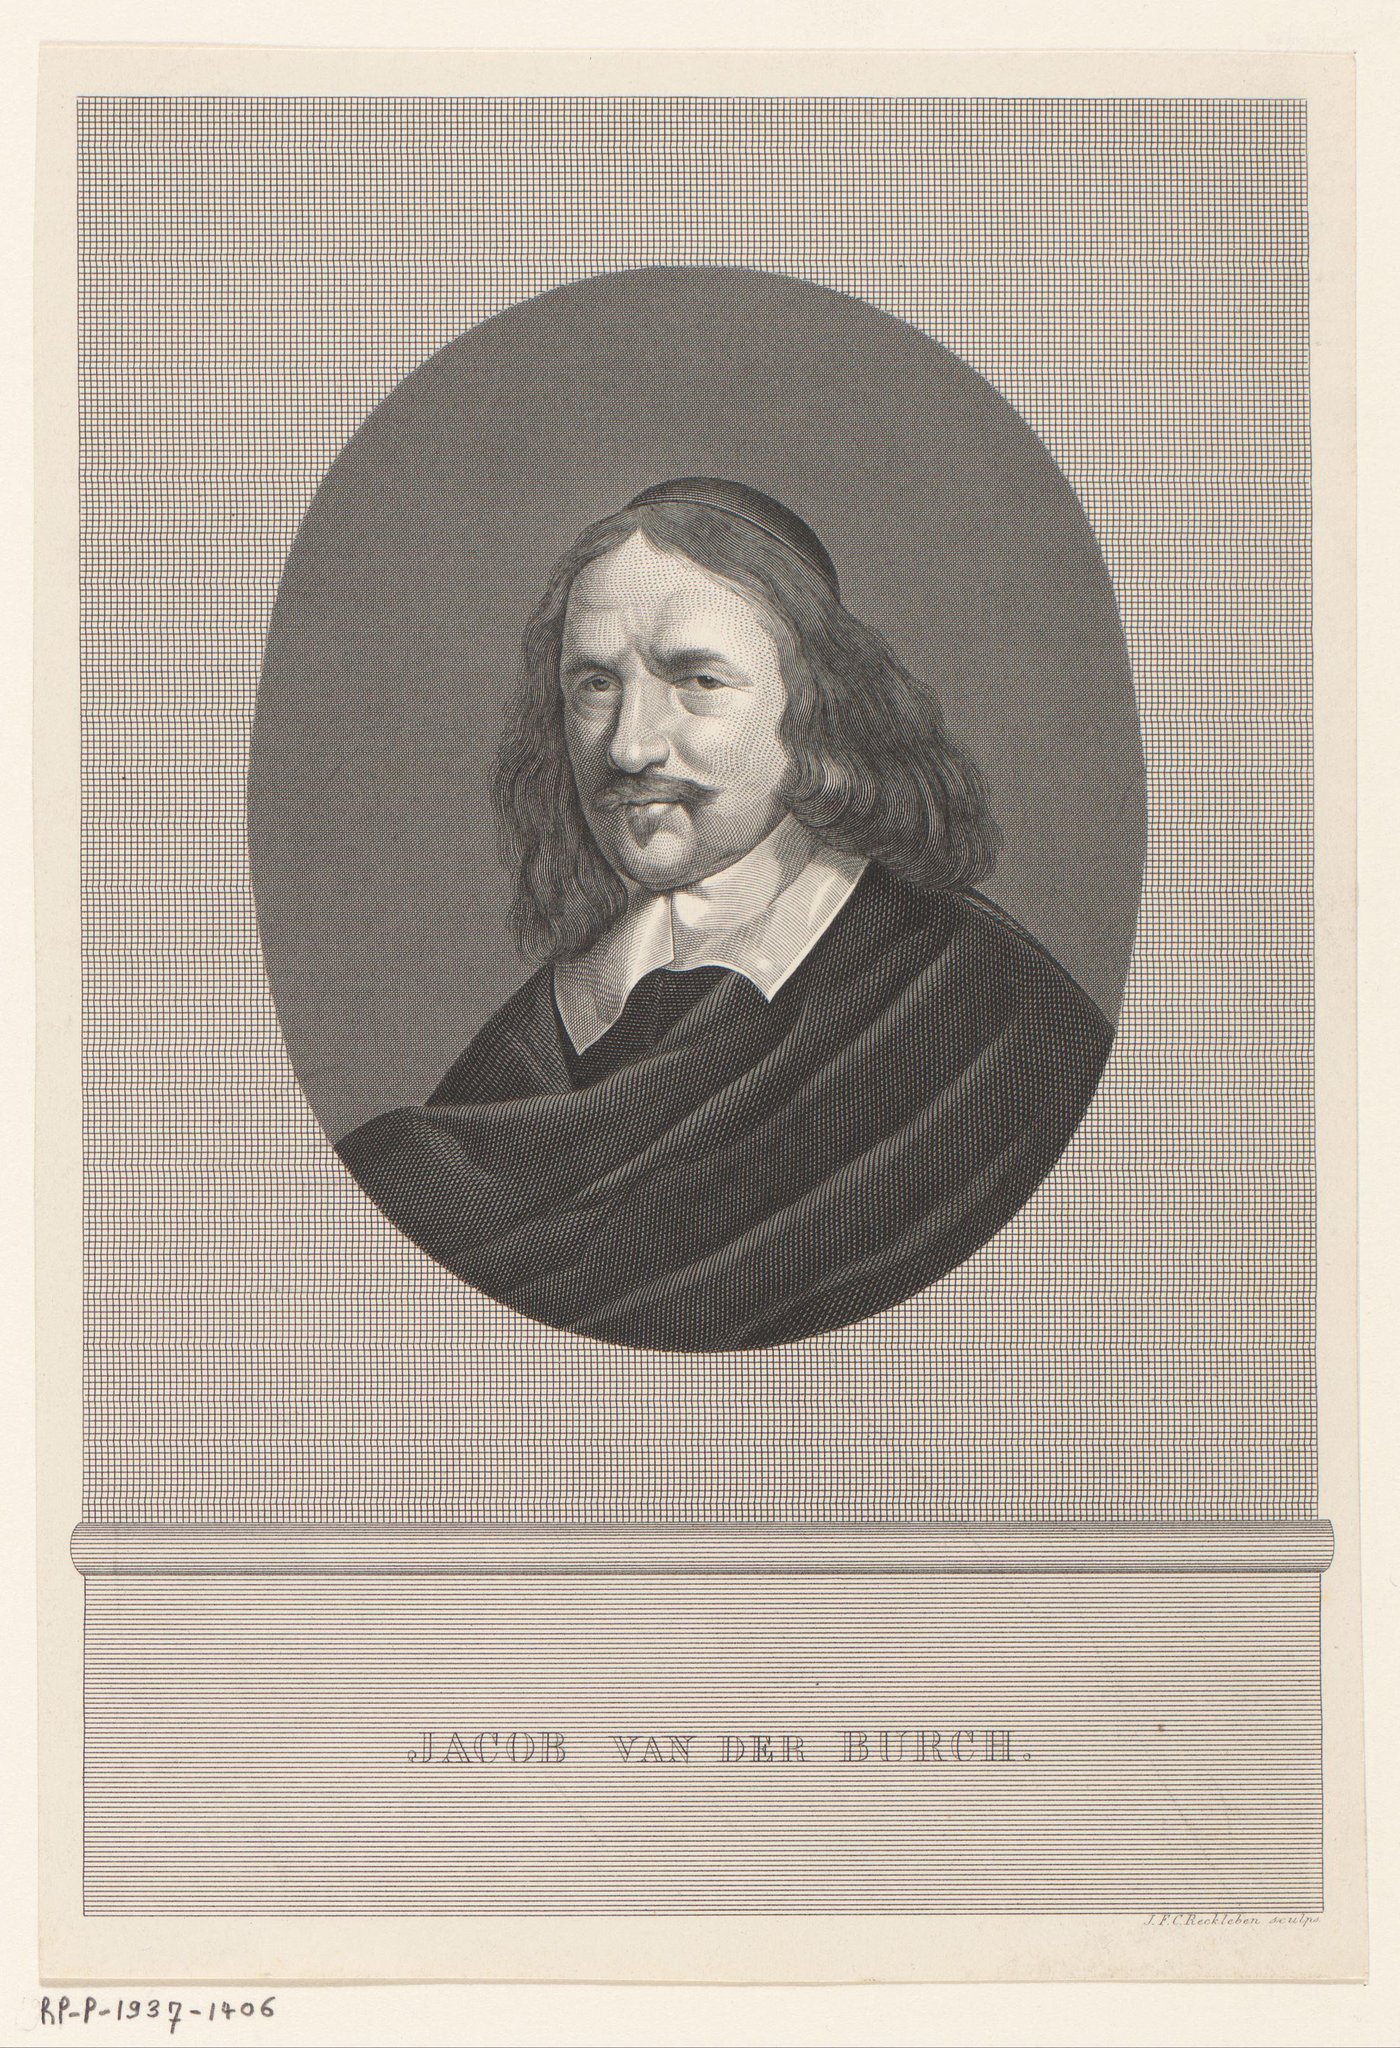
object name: print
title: Portret van Jacob van den Burgh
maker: jan frederik christiaan reckleben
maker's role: print maker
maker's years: 1819-1879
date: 1866-1868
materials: paper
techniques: engraving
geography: amsterdam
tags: jacob van der burgh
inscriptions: collector's mark: Lugt 2228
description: Illustratie in: Arend, Johannes Pieter. Algemeene geschiedenis des vaderlands van de vroegste tijden tot op heden. 5 delen, Amsterdam: Schleijer, J.F. 1840-1884, dl. 3.5, p. 750.